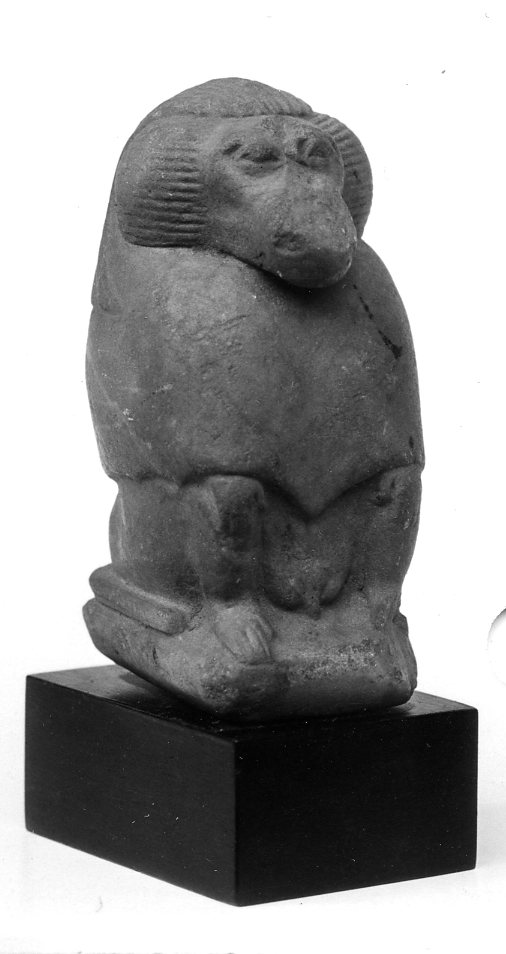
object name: figurine, baboon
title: Figure of a Baboon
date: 664-332 BCE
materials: marble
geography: egypt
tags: baboons